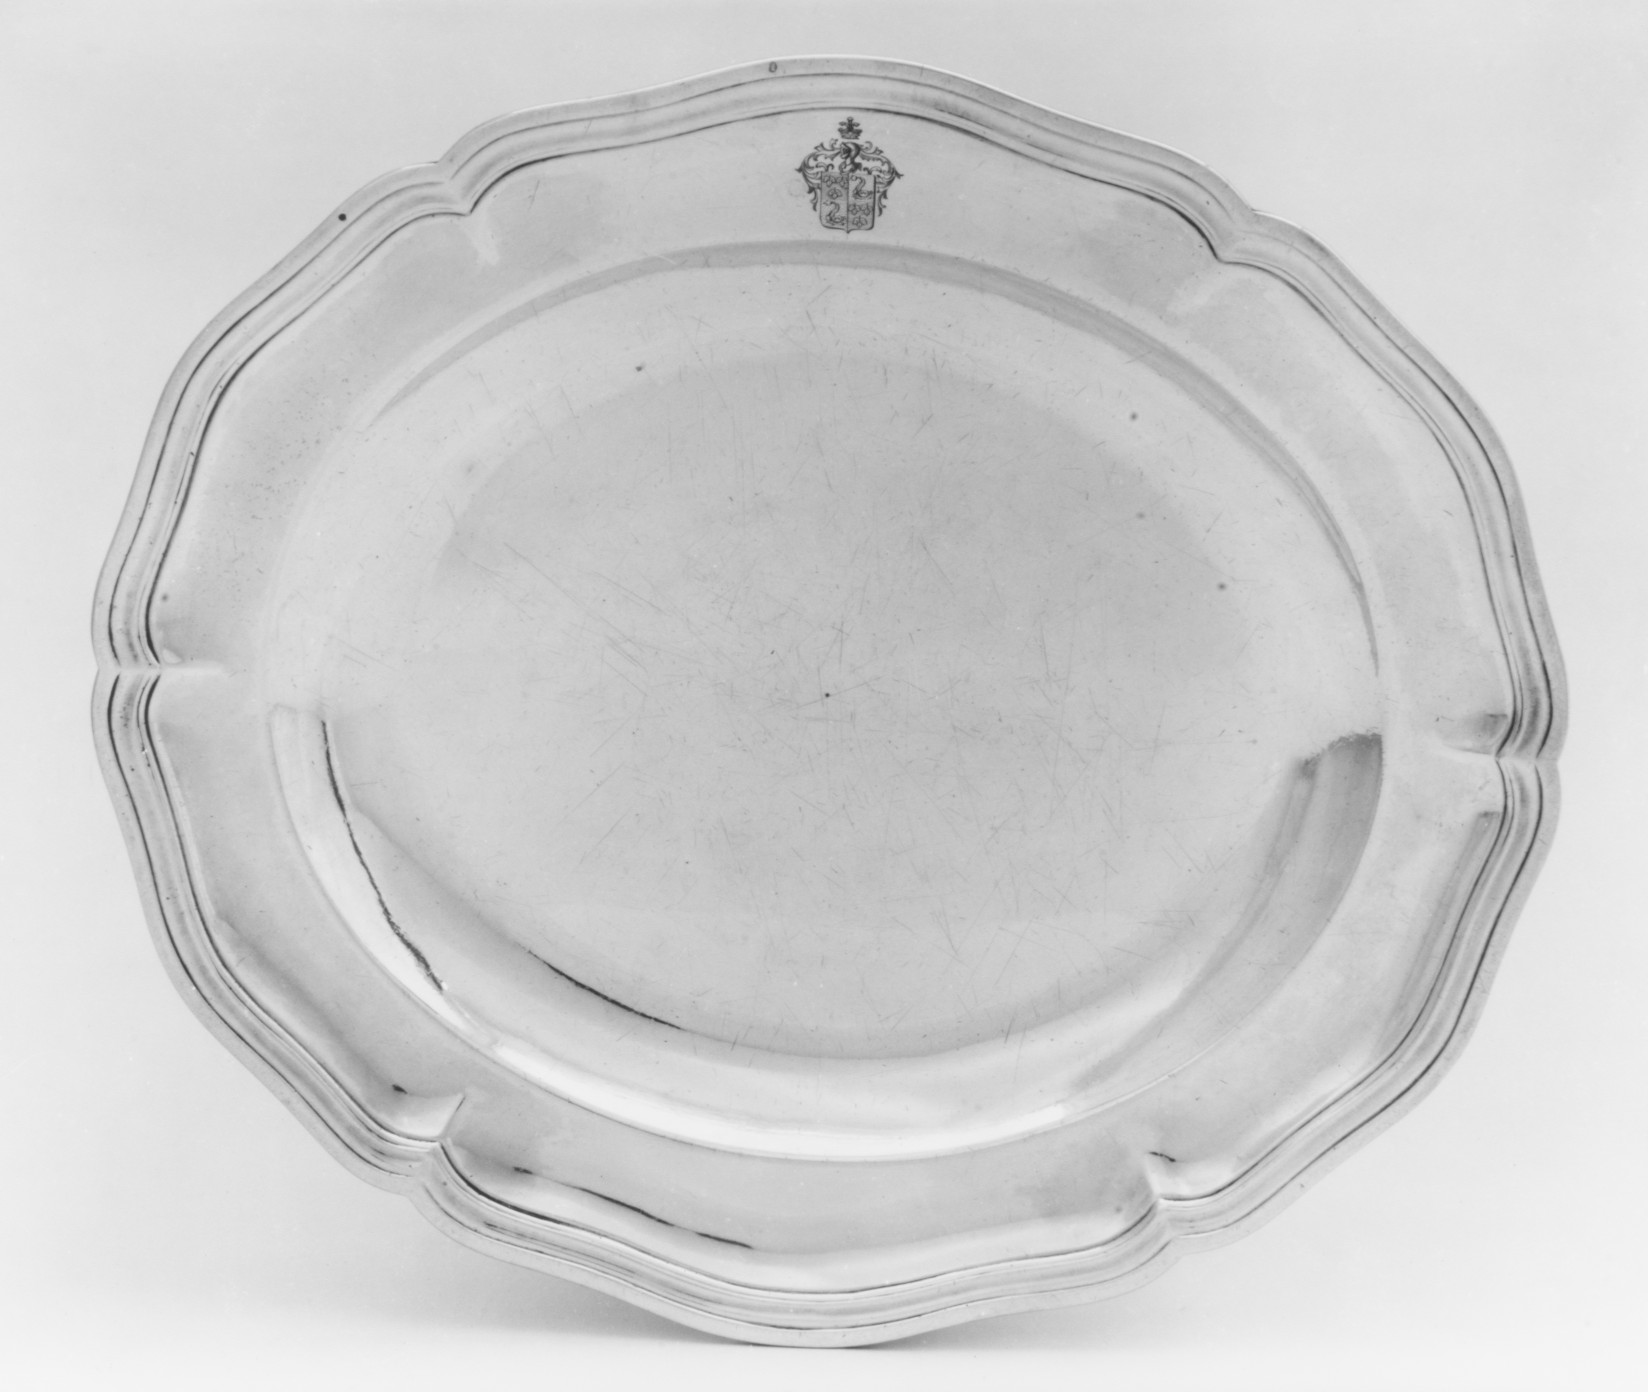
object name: platter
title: Platter (one of a set, of graduated sizes)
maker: jacques bernier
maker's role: maker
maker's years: 1751-1823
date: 1786-1788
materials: silver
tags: coat of arms